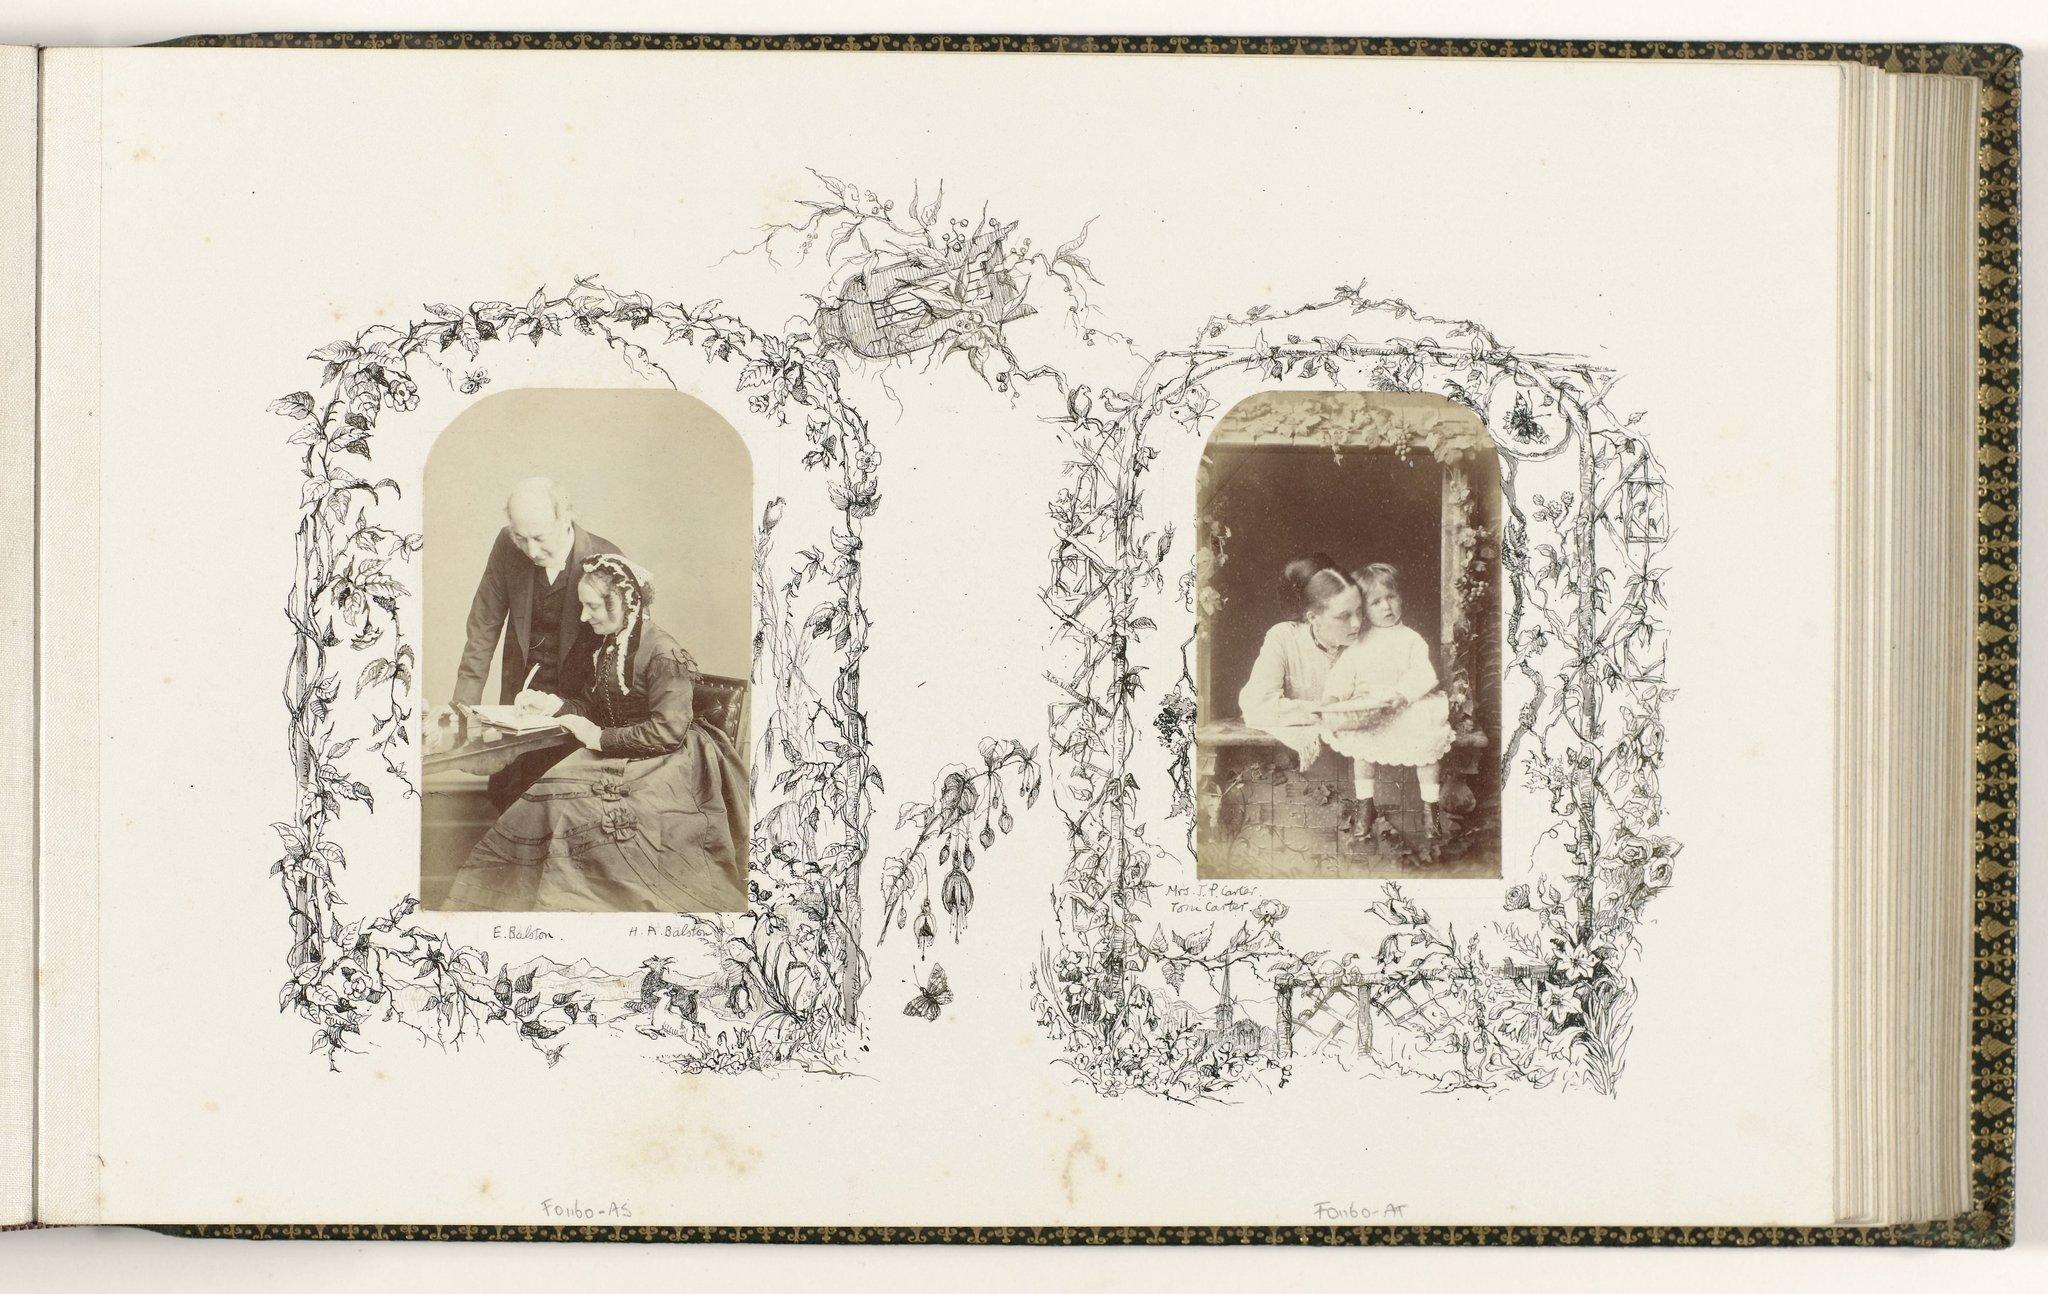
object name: album leaf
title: Portret van mevrouw T.P. Carter en Tom Carter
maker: Anonymous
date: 1865-1875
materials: paper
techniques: albumen print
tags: historical persons, mother and baby or young child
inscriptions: inscription: ‘Mrs. T.P. Carter/ Tom Carter’